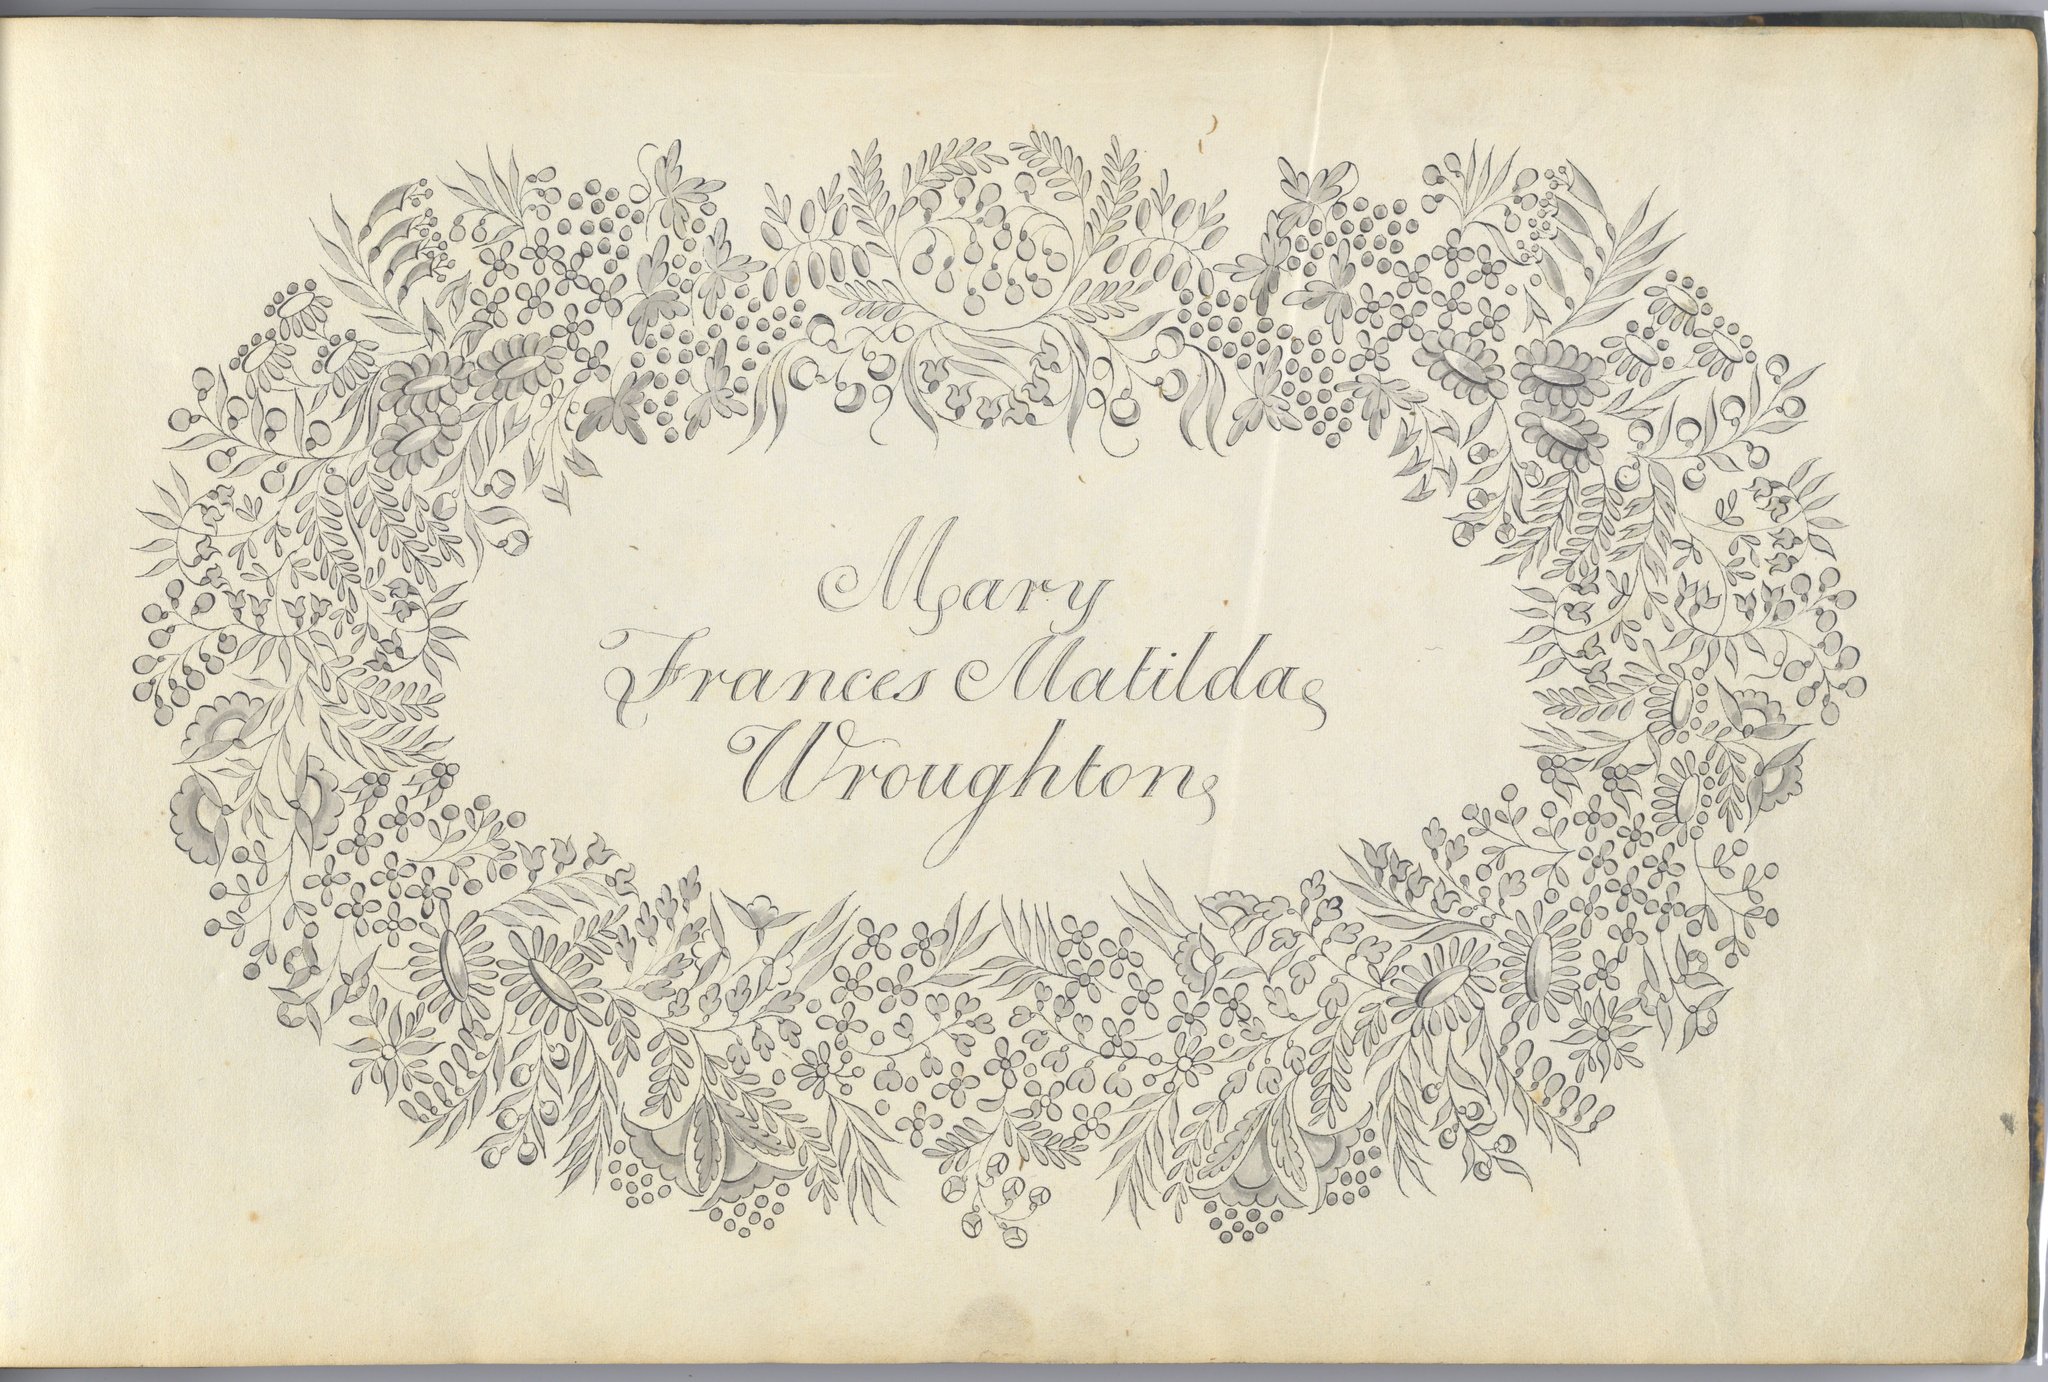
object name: book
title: Copy Book of Embroidery Patterns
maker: mary frances matilda wroughton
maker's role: artist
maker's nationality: british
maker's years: 1780-1880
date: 1830-1835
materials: graphite, ink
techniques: pen